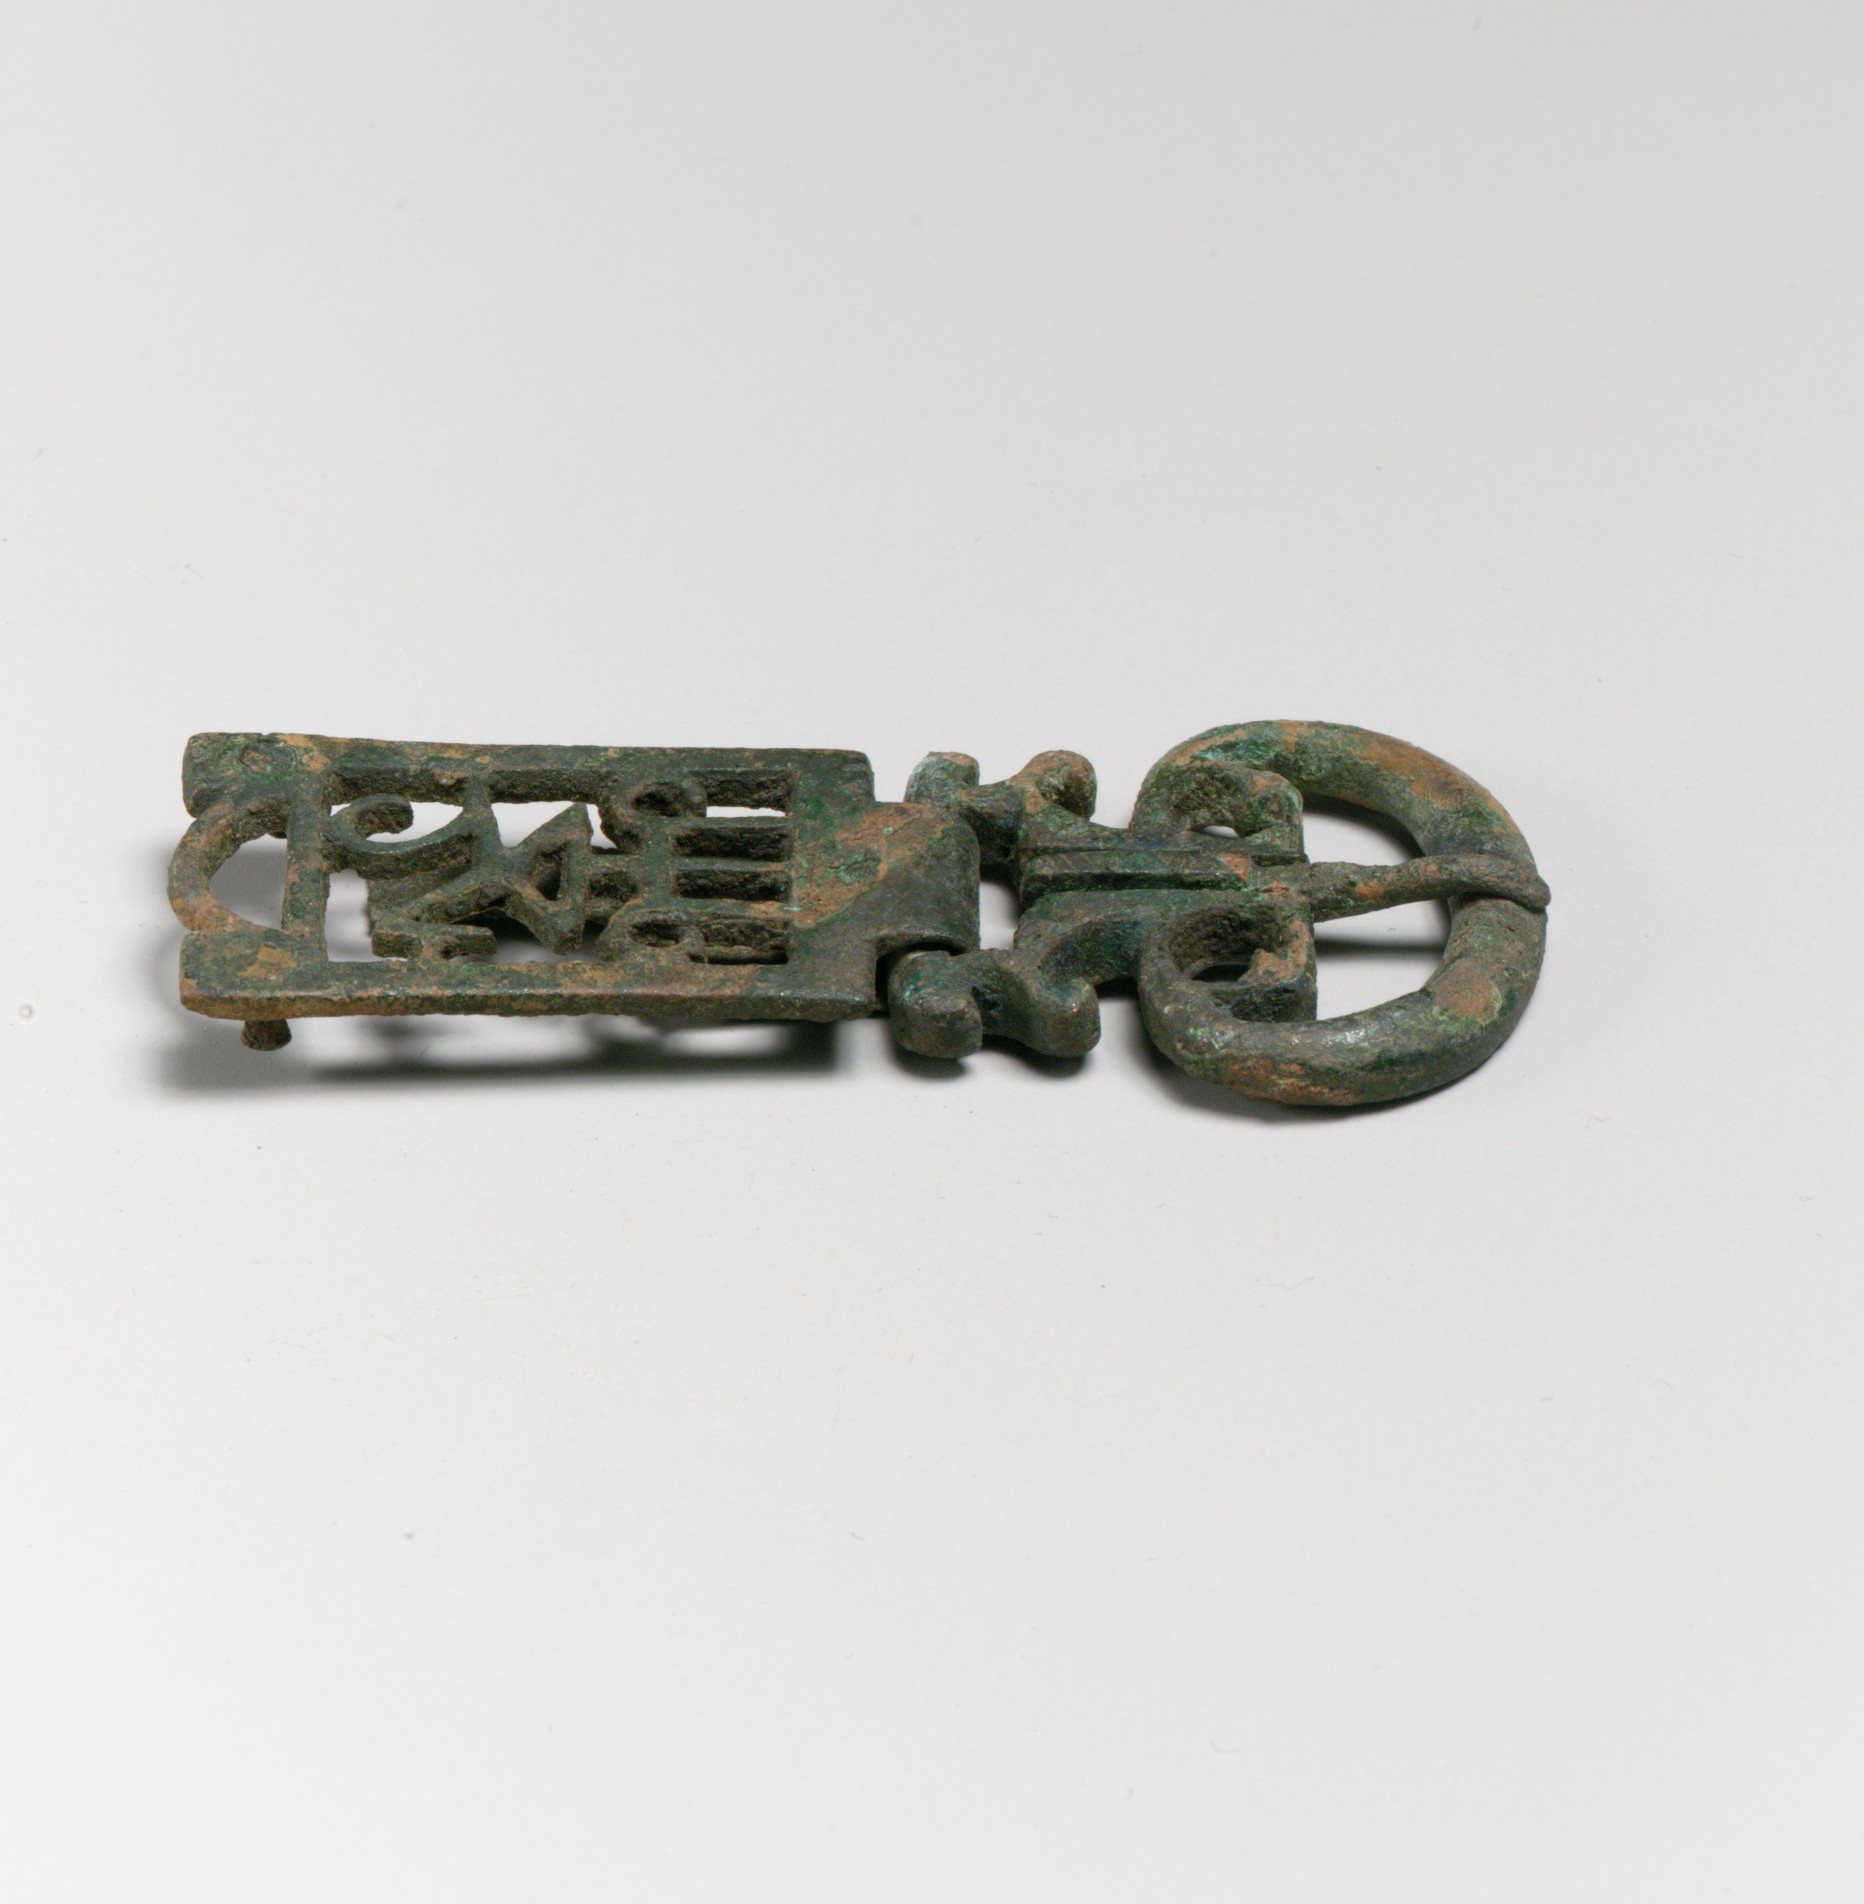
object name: buckle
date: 7000 BCE-330 CE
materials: bronze